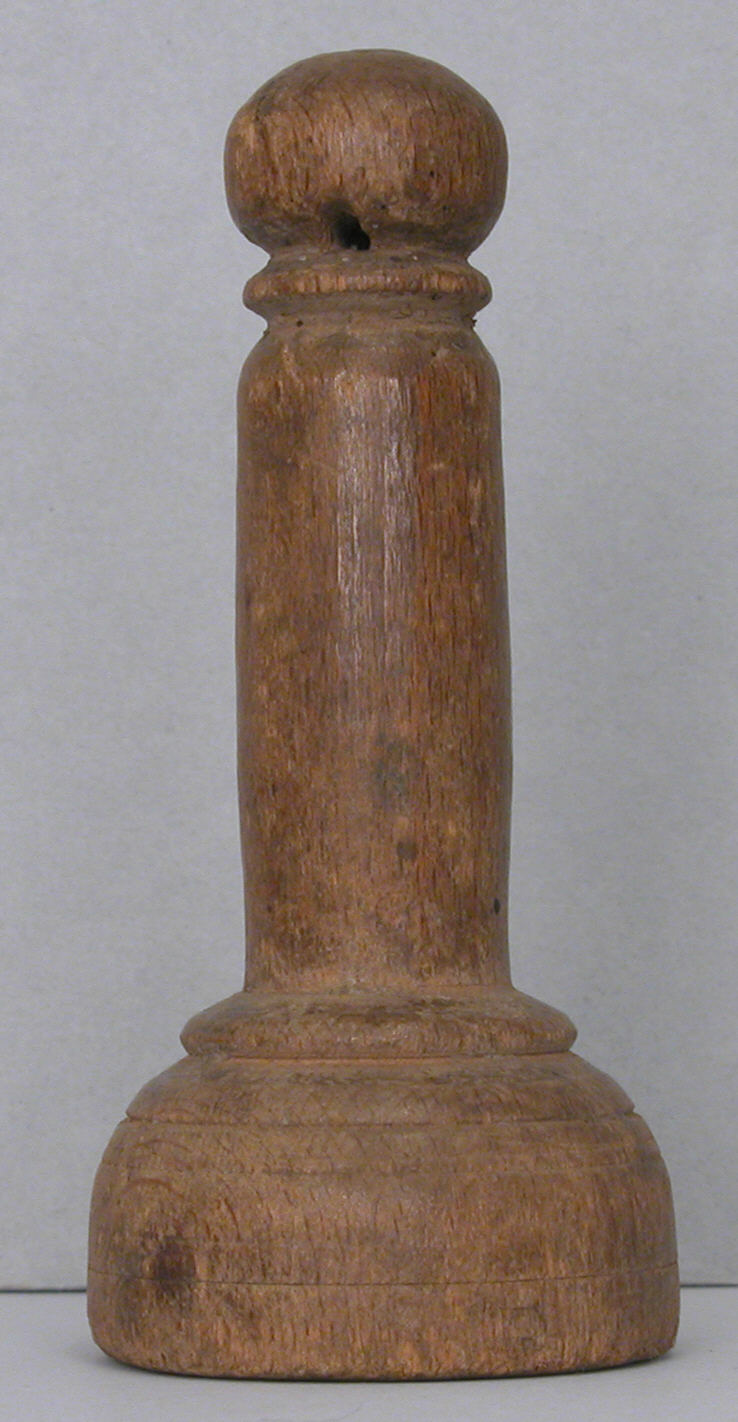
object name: stamp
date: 1101-1900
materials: wood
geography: egypt